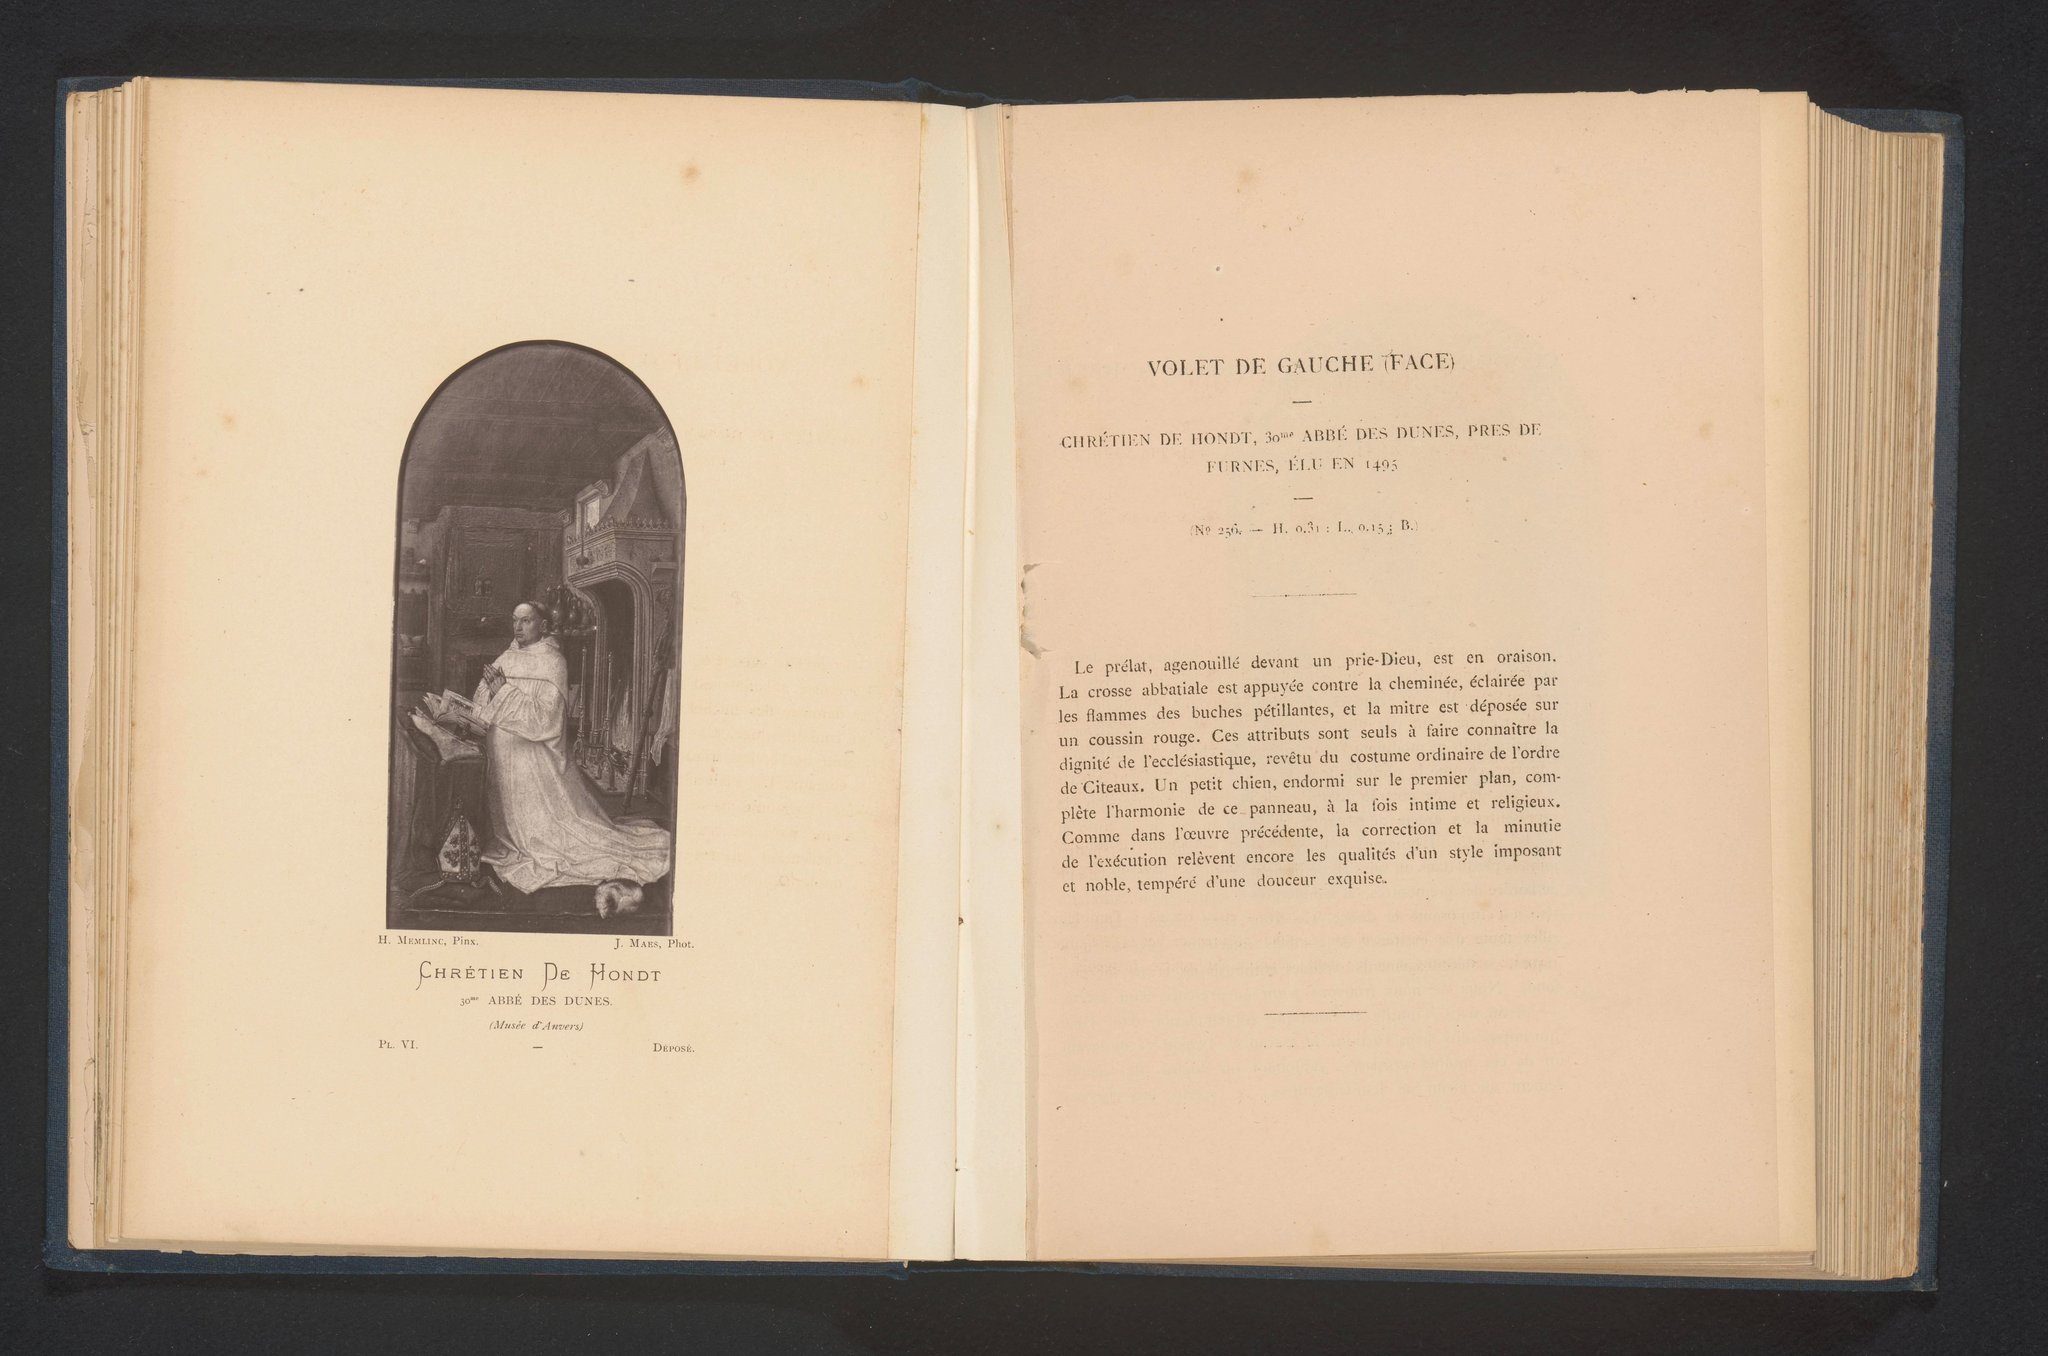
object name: page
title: Reproductie van een schilderij van een portret van Chrétien de Hondt door Hans Memling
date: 1872-1877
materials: paper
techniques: woodburytype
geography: antwerp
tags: one person praying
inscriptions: inscription: ‘30me ABBÉS DES DUNES./ (Musée d'Anvers)/ Pl. VI. Déposé.’